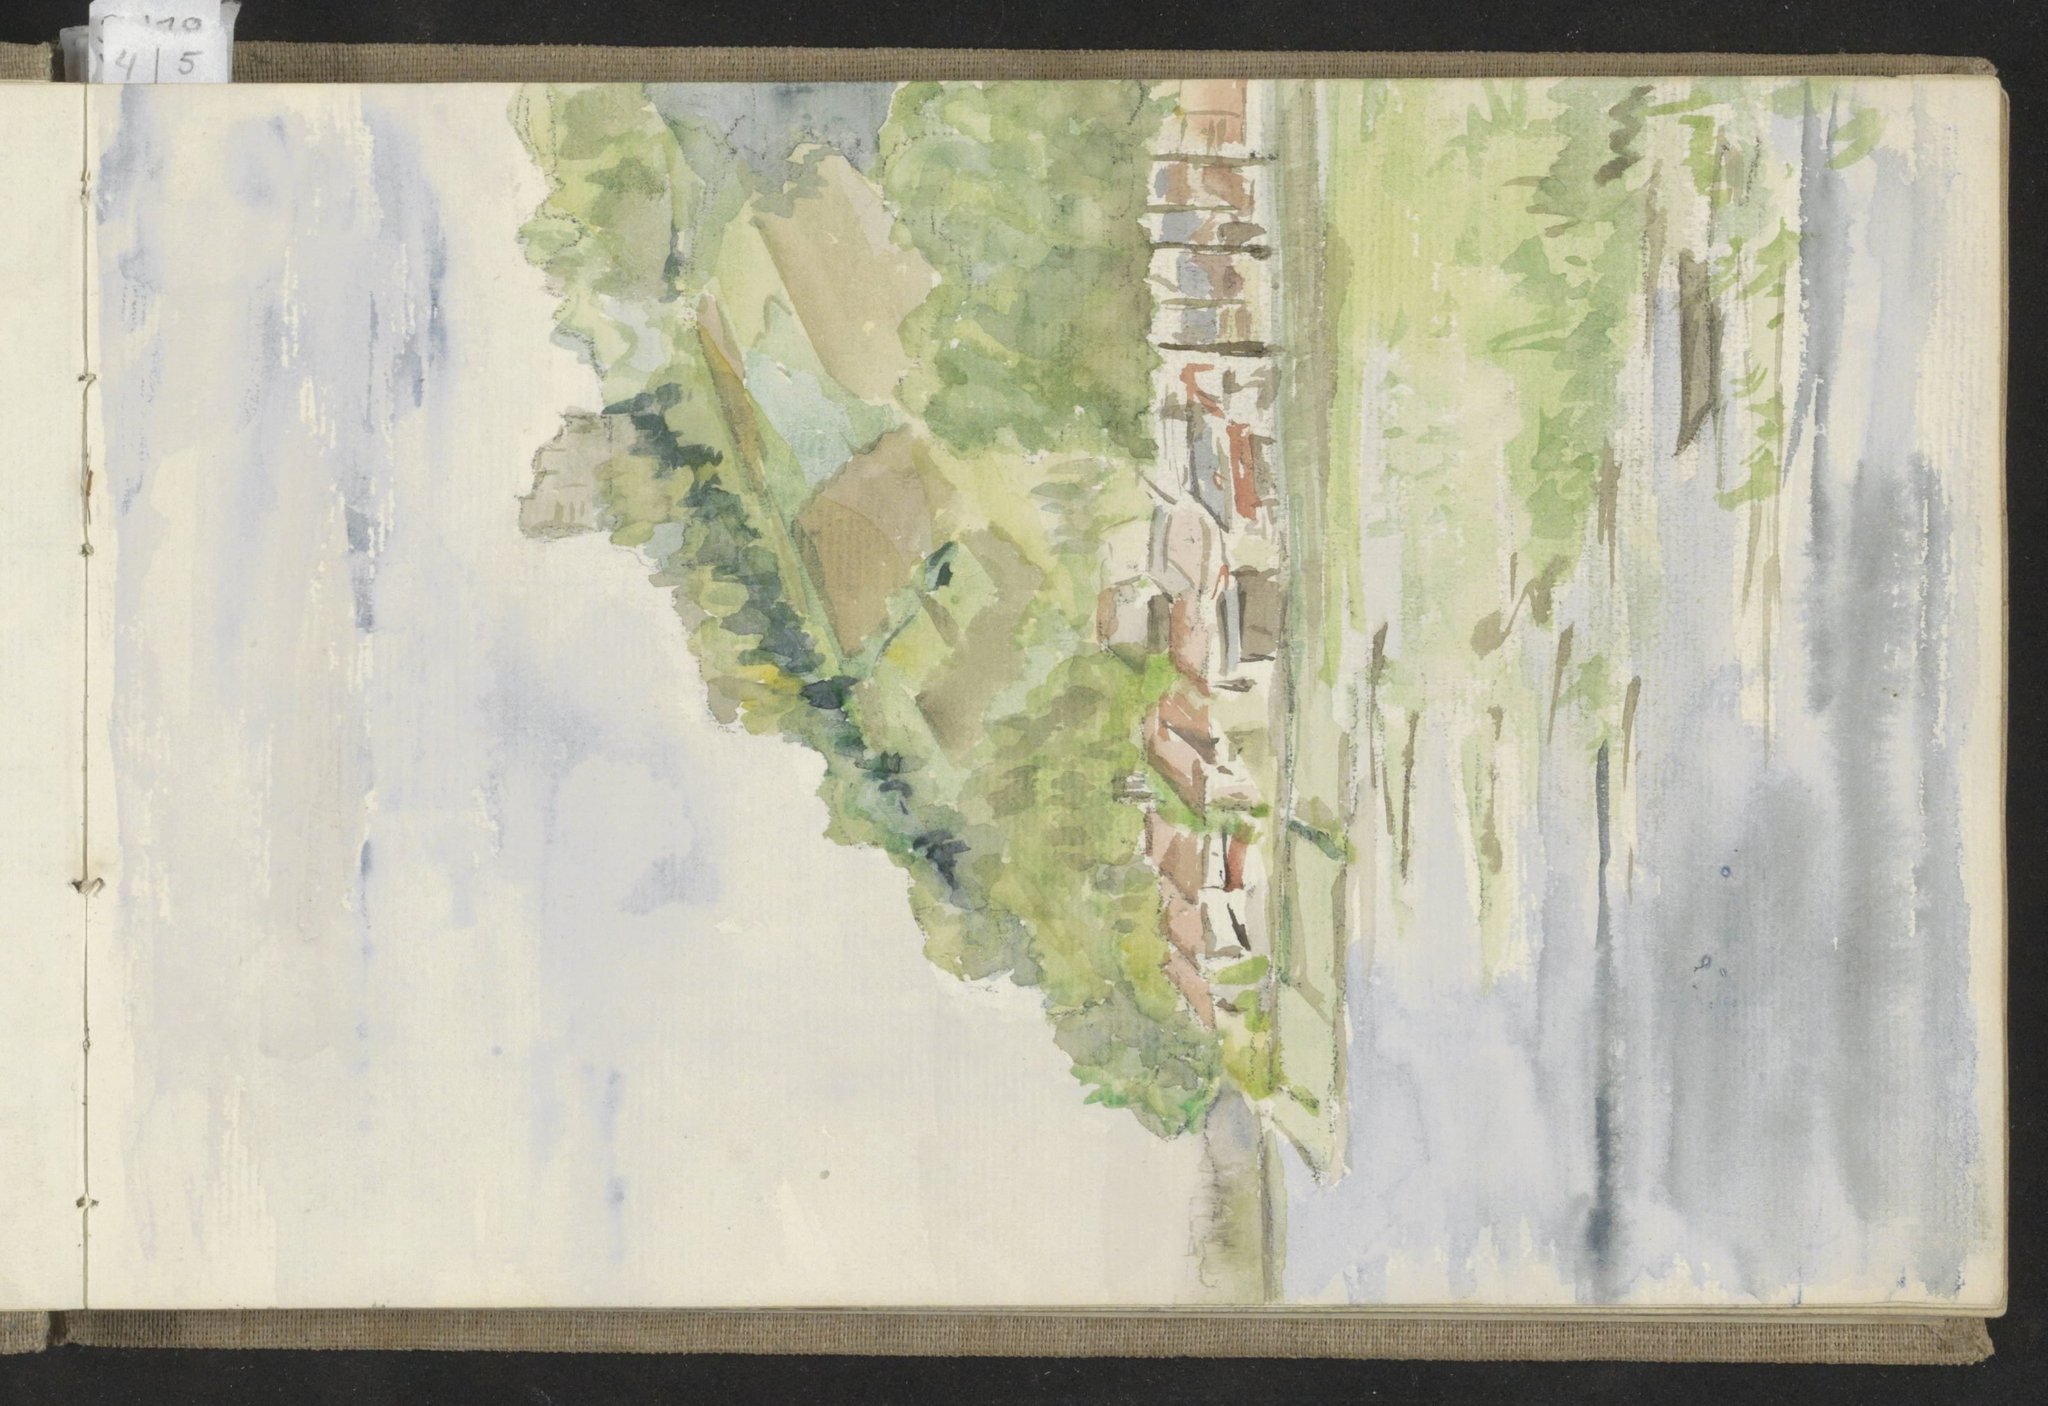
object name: sketchbook leaf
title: Dorp aan een waterkant bij een berg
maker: jonkheer johannes ludovicus paulus bosch van drakestein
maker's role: draughtsman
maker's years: 1865-1929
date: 1896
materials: paper, pencil, watercolor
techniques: brush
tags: prospect of village, silhouette of village, landscapes with waters, waterscapes, seascapes (in the temperate zone), mountains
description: Blad 4 recto uit een schetsboek met 58 bladen.